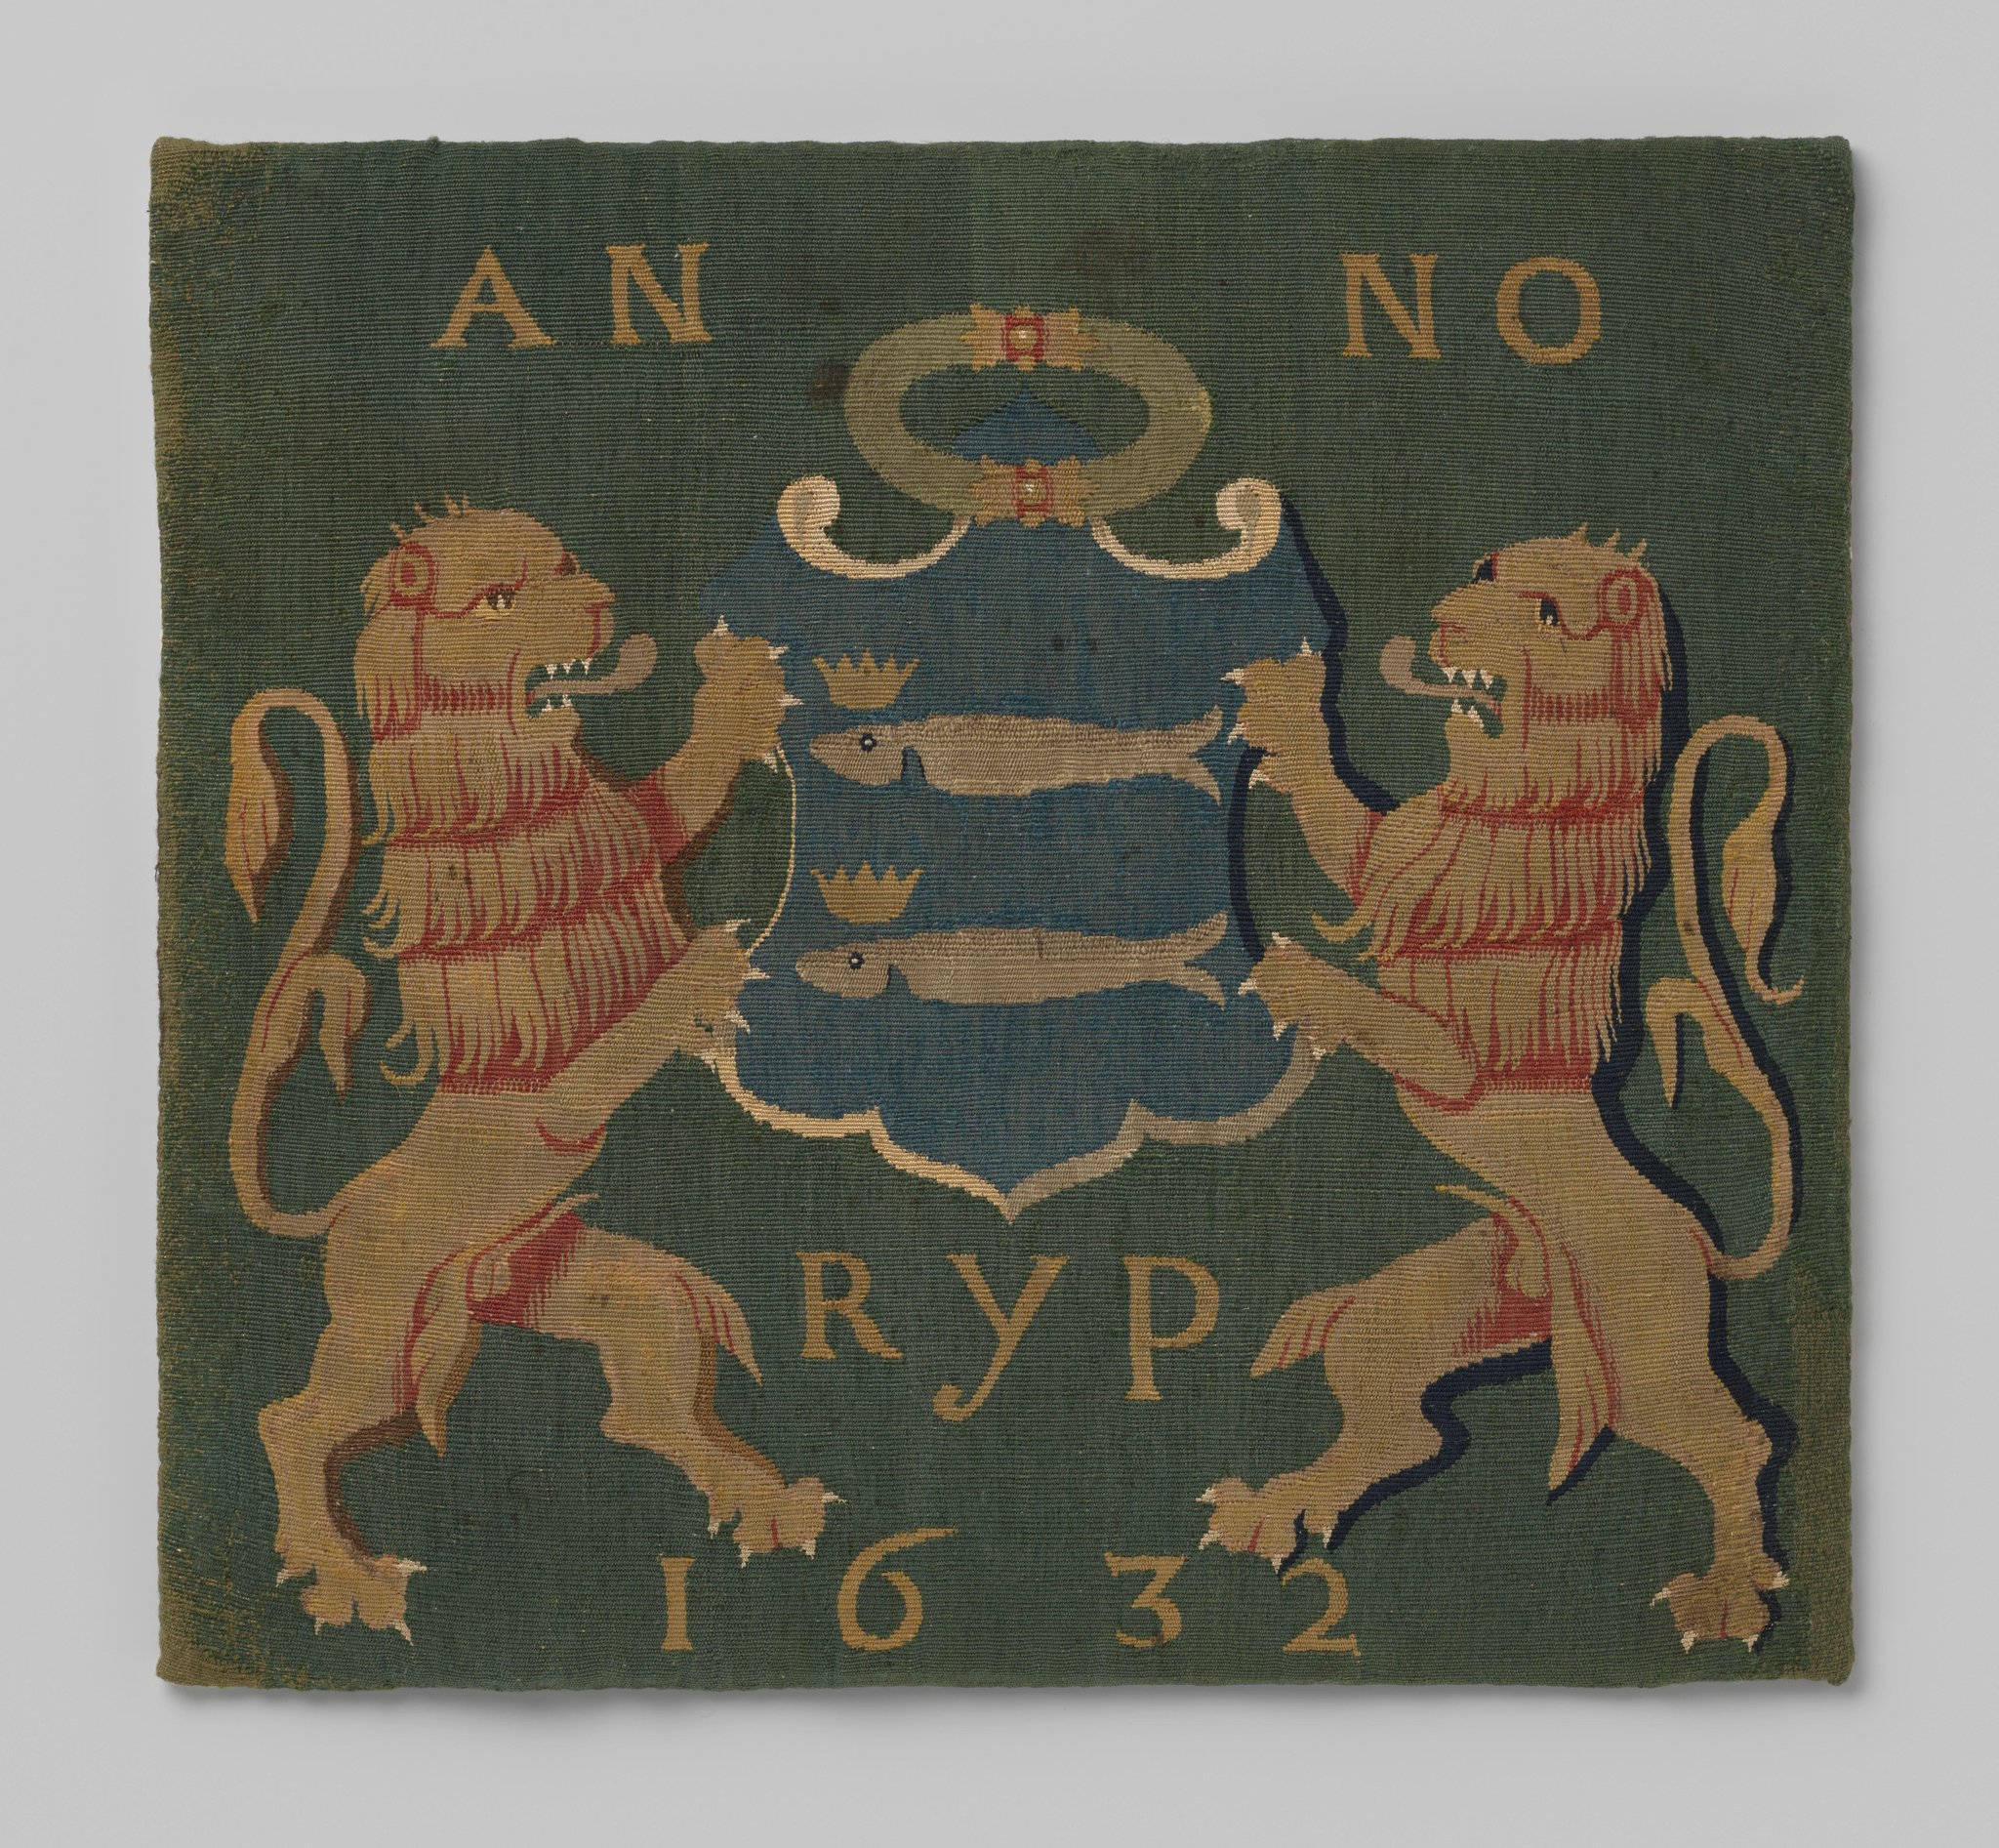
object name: kussenblad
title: Kussenblad met het gemeentewapen van De Rijp en jaartal 1632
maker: Anonymous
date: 1632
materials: silk, wool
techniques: tapestry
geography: northern netherlands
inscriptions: date: ‘AN NO // 1732’, inscription: ‘RYP’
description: Kussenblad van een magistratenkussen van tapijtweefsel met het gemeentewapen van de Rijp en als schildhouders twee leeuwen. Boven en onder het wapen de inscriptie "ANNO", "RYP" en het jaartal 1632.